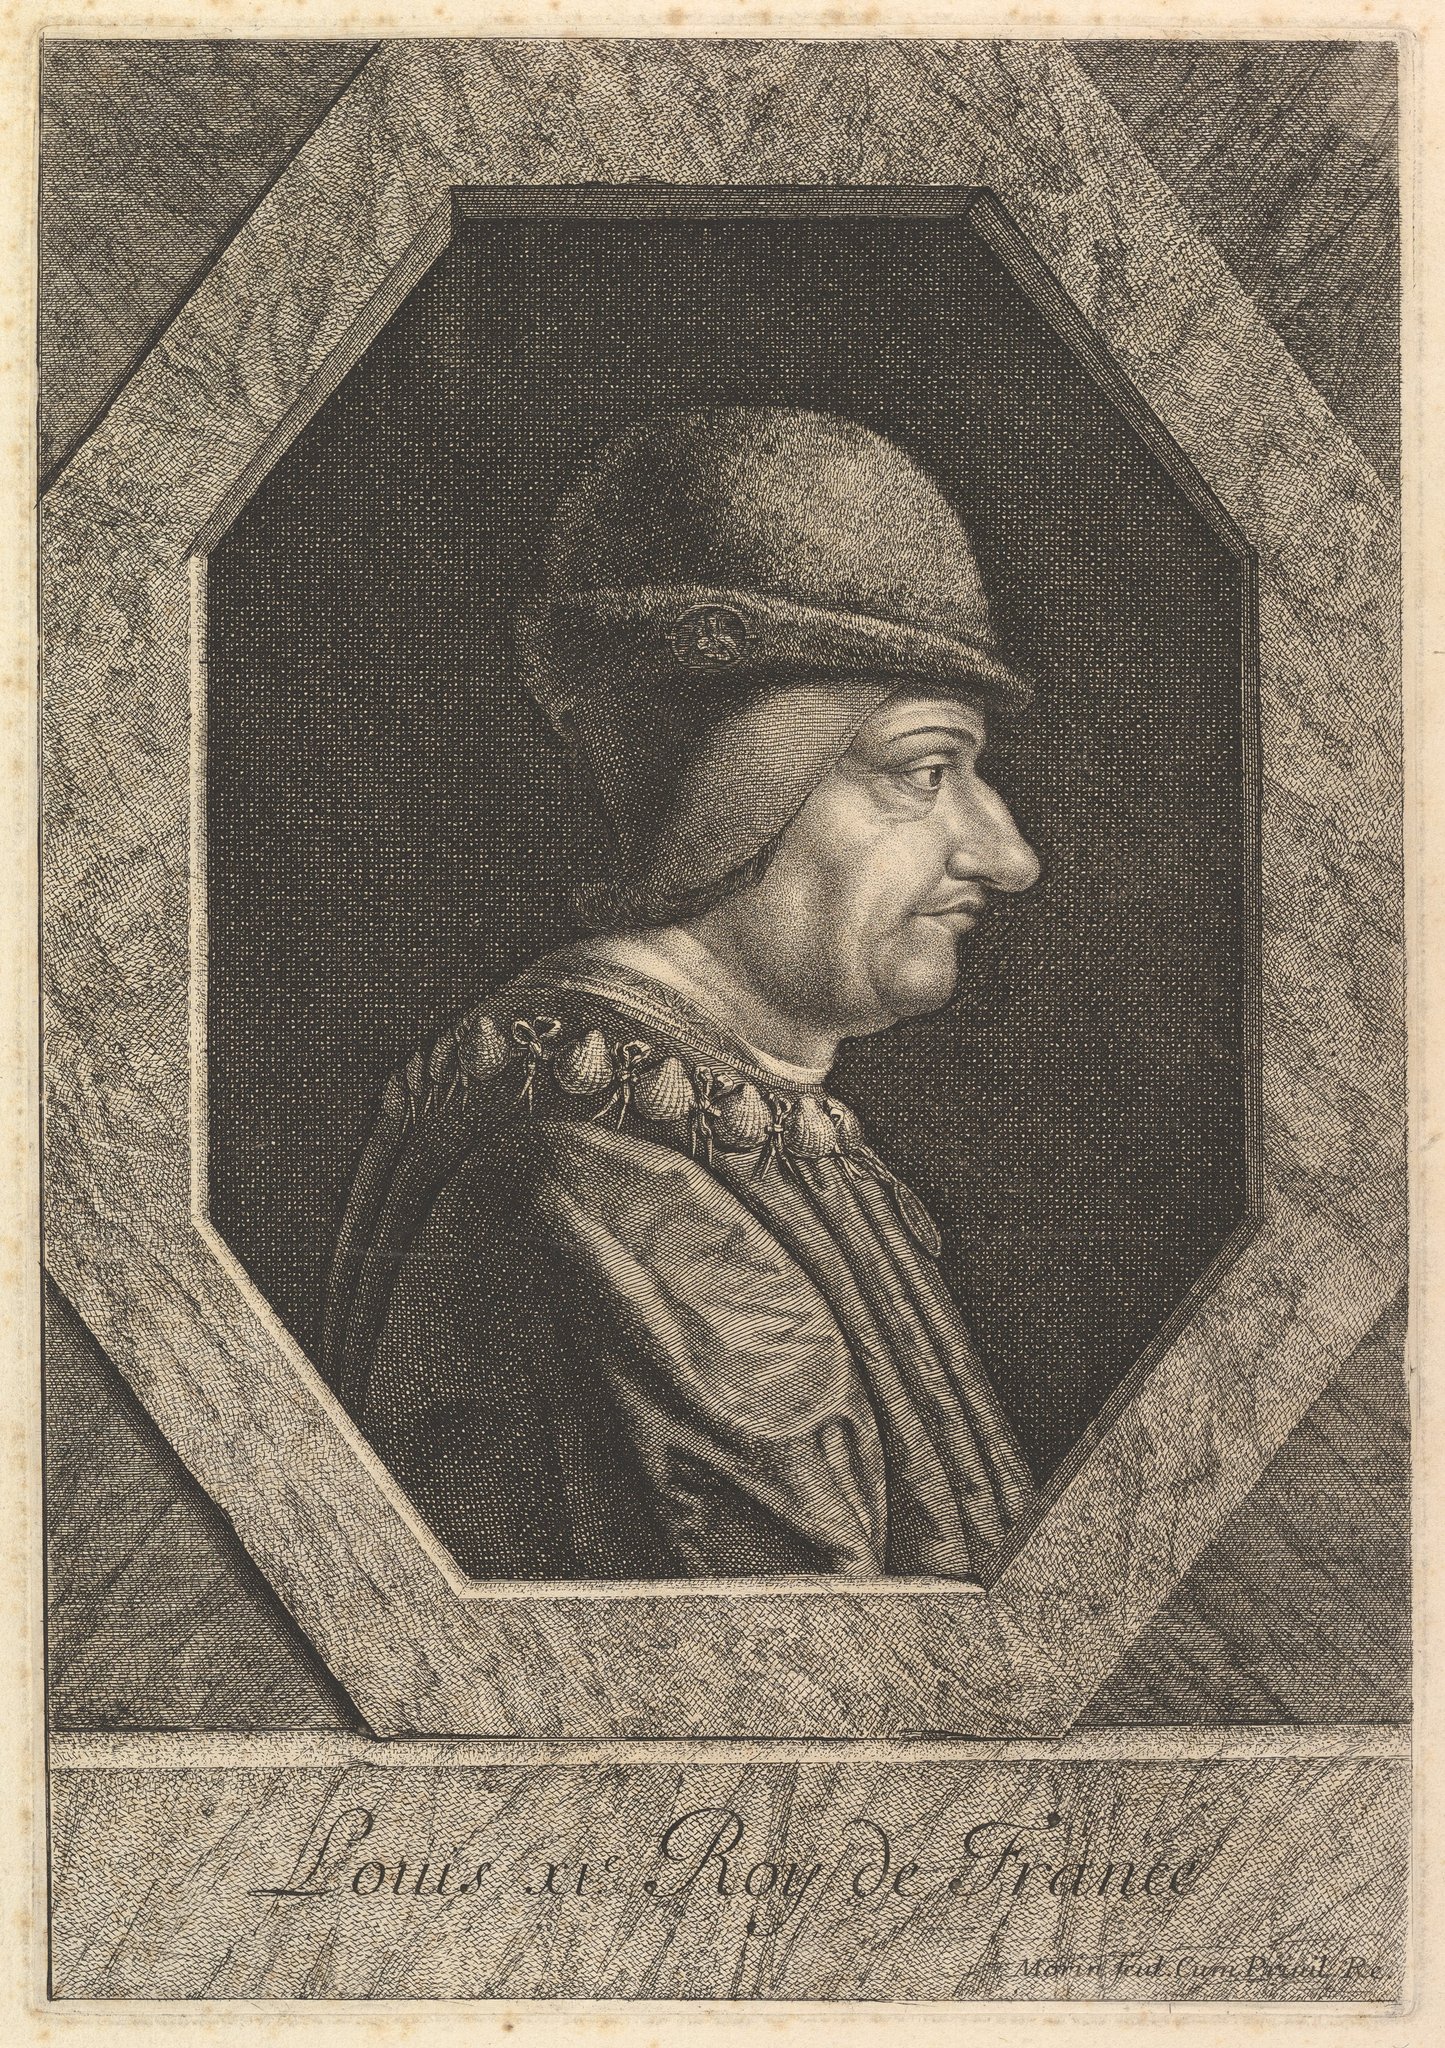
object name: print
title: Louis XI, roi de France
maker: jean morin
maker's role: artist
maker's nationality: french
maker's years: 1605-1650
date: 1605-1650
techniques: etching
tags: kings,portraits